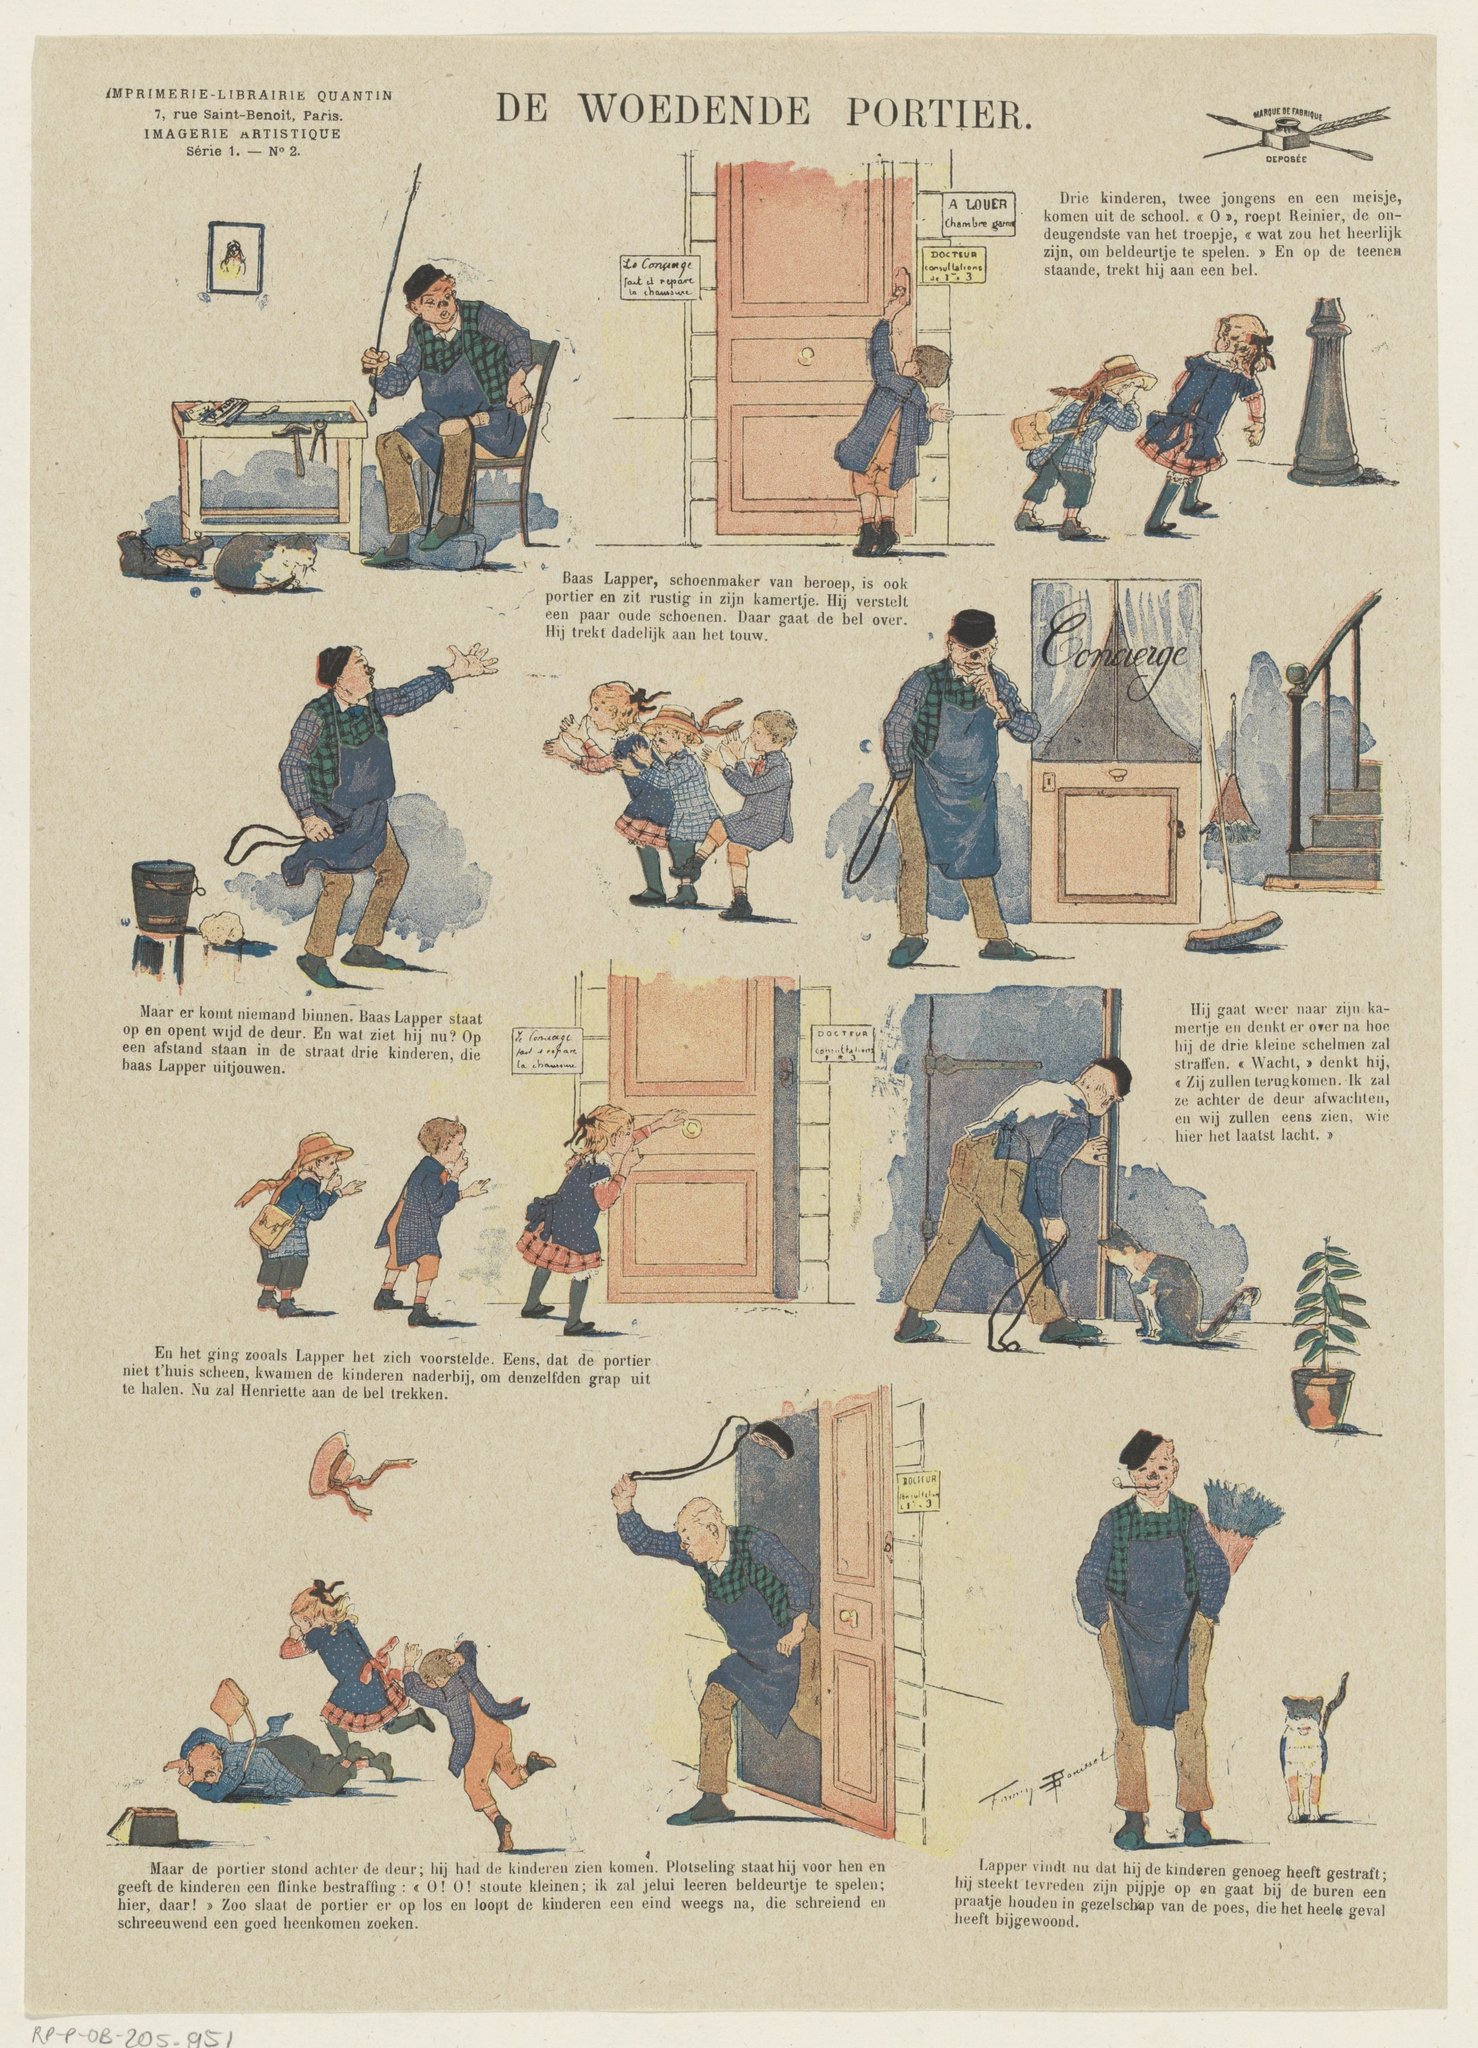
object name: print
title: Imagerie Artistique / Série 1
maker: albert quantin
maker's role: printer, publisher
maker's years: 1850-1933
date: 1876-1890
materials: paper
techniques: lithograph, letterpress printing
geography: paris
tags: correction of naughty children, ringing doorbells (mischief-making), tales and fairy tales, shoe-maker, cobbler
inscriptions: collector's mark: Lugt 2760, : ‘marque de fabrique / deposée’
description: Blad met 4 rijen met voorstellingen van kinderen die belletje trekken bij een kwade schoenmaker. Onder elke voorstelling een onderschrift. Genummerd linksboven: Série 1. - No. 2.